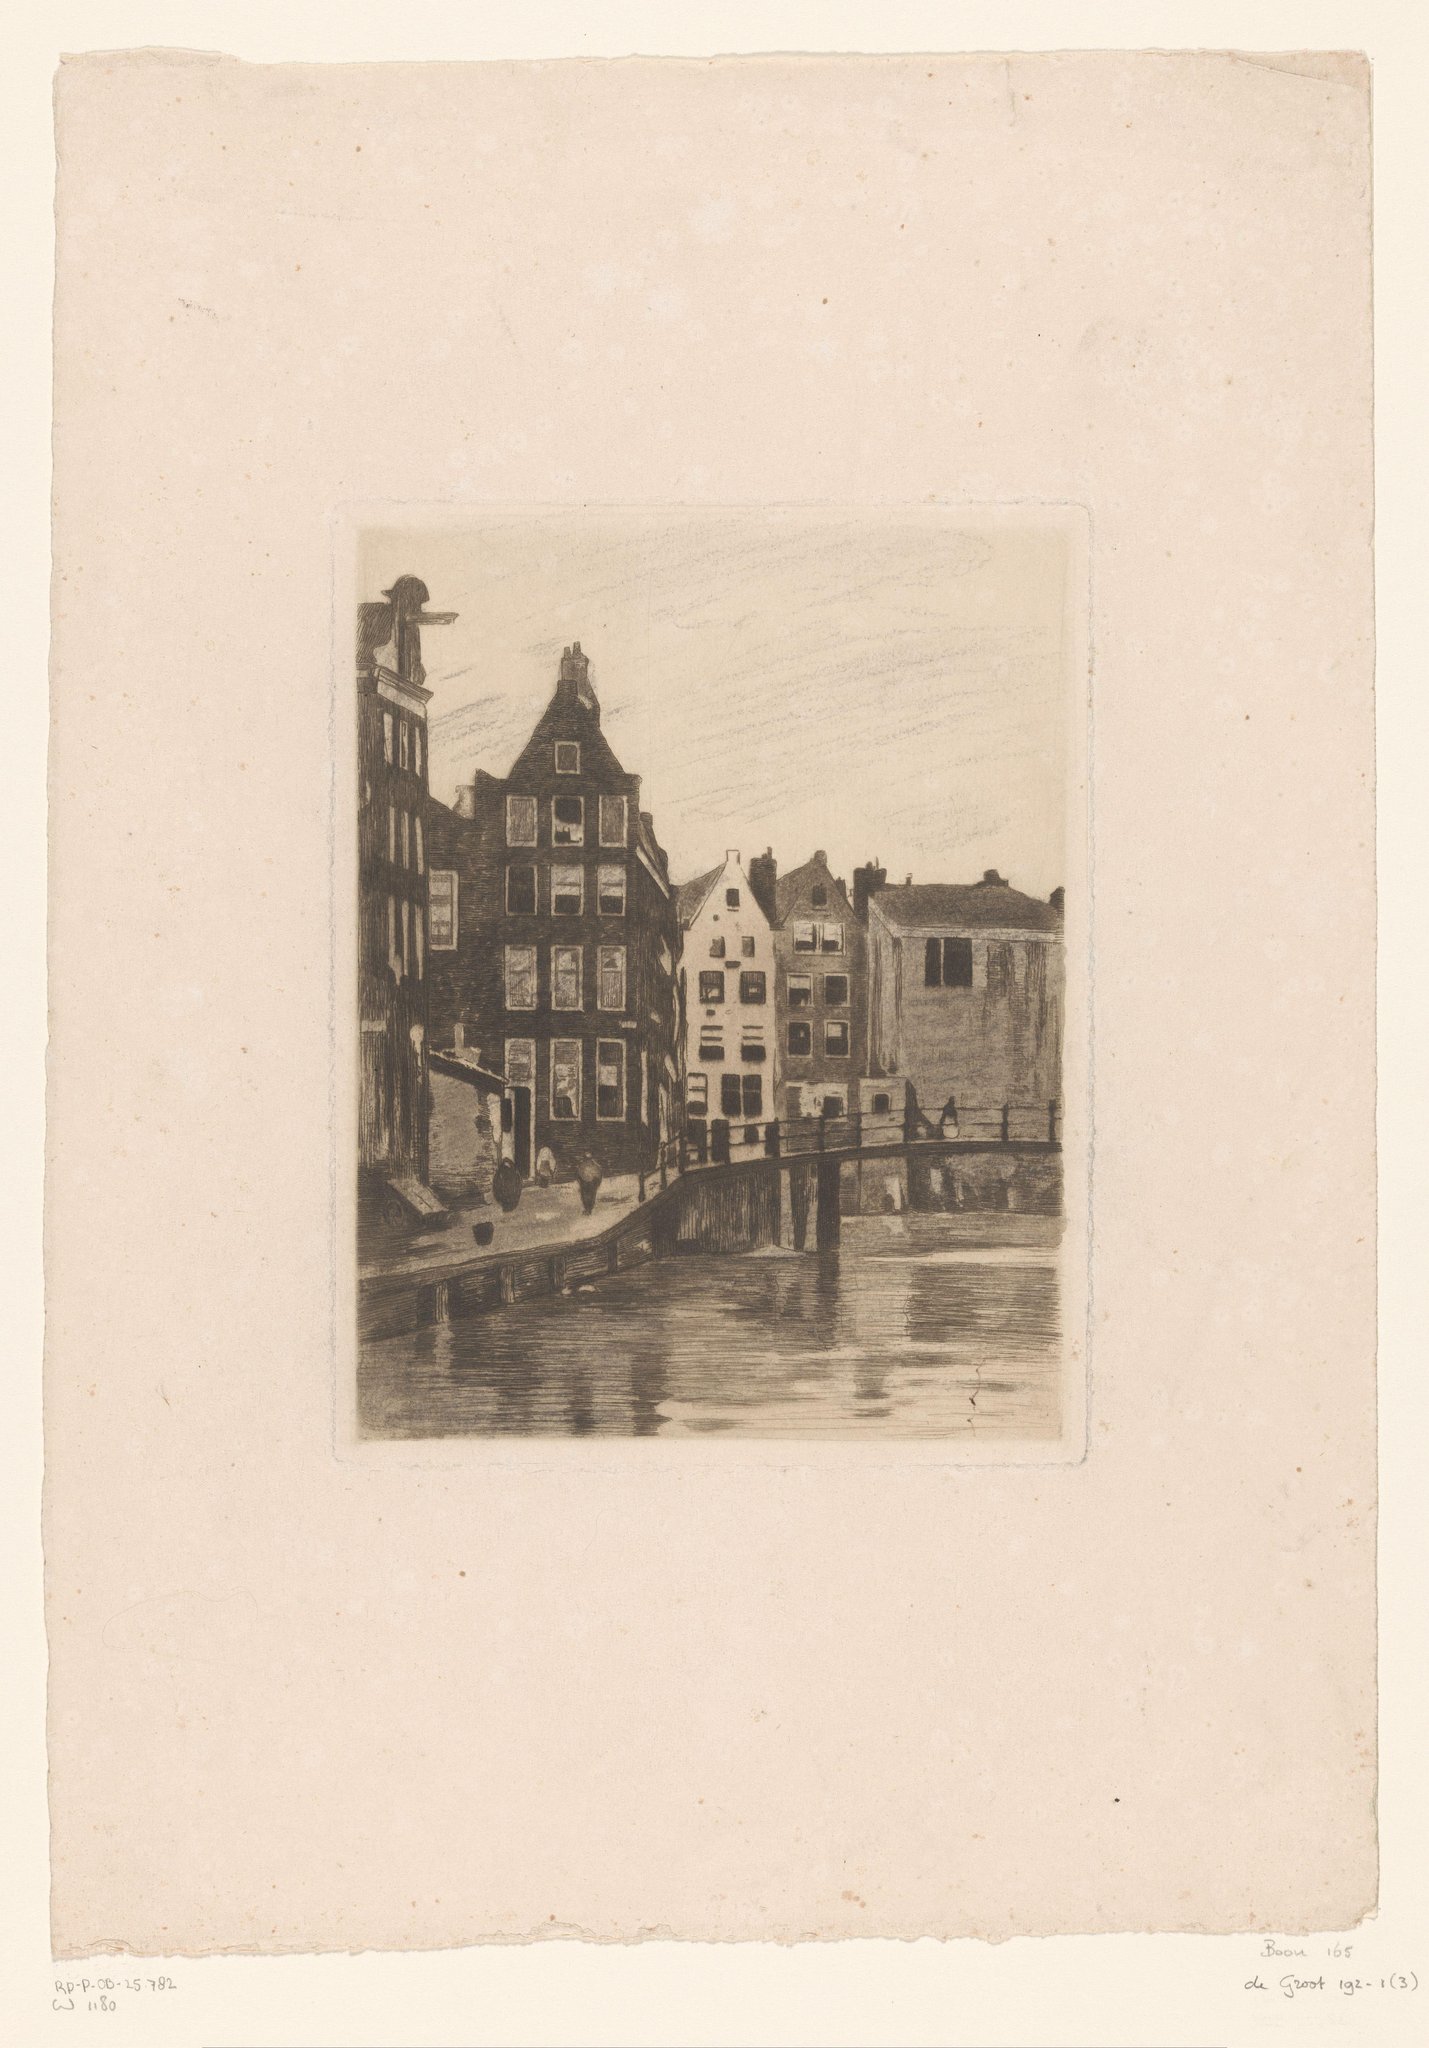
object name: print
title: Gezicht op huizen en een brug in Amsterdam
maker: willem witsen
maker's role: draughtsman, painter, print maker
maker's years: 1860-1923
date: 1915-1919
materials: chalk, paper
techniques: aquatint, etching, intaglio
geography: amsterdam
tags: urban housing, canals, waters (in city), bridge, amsterdam